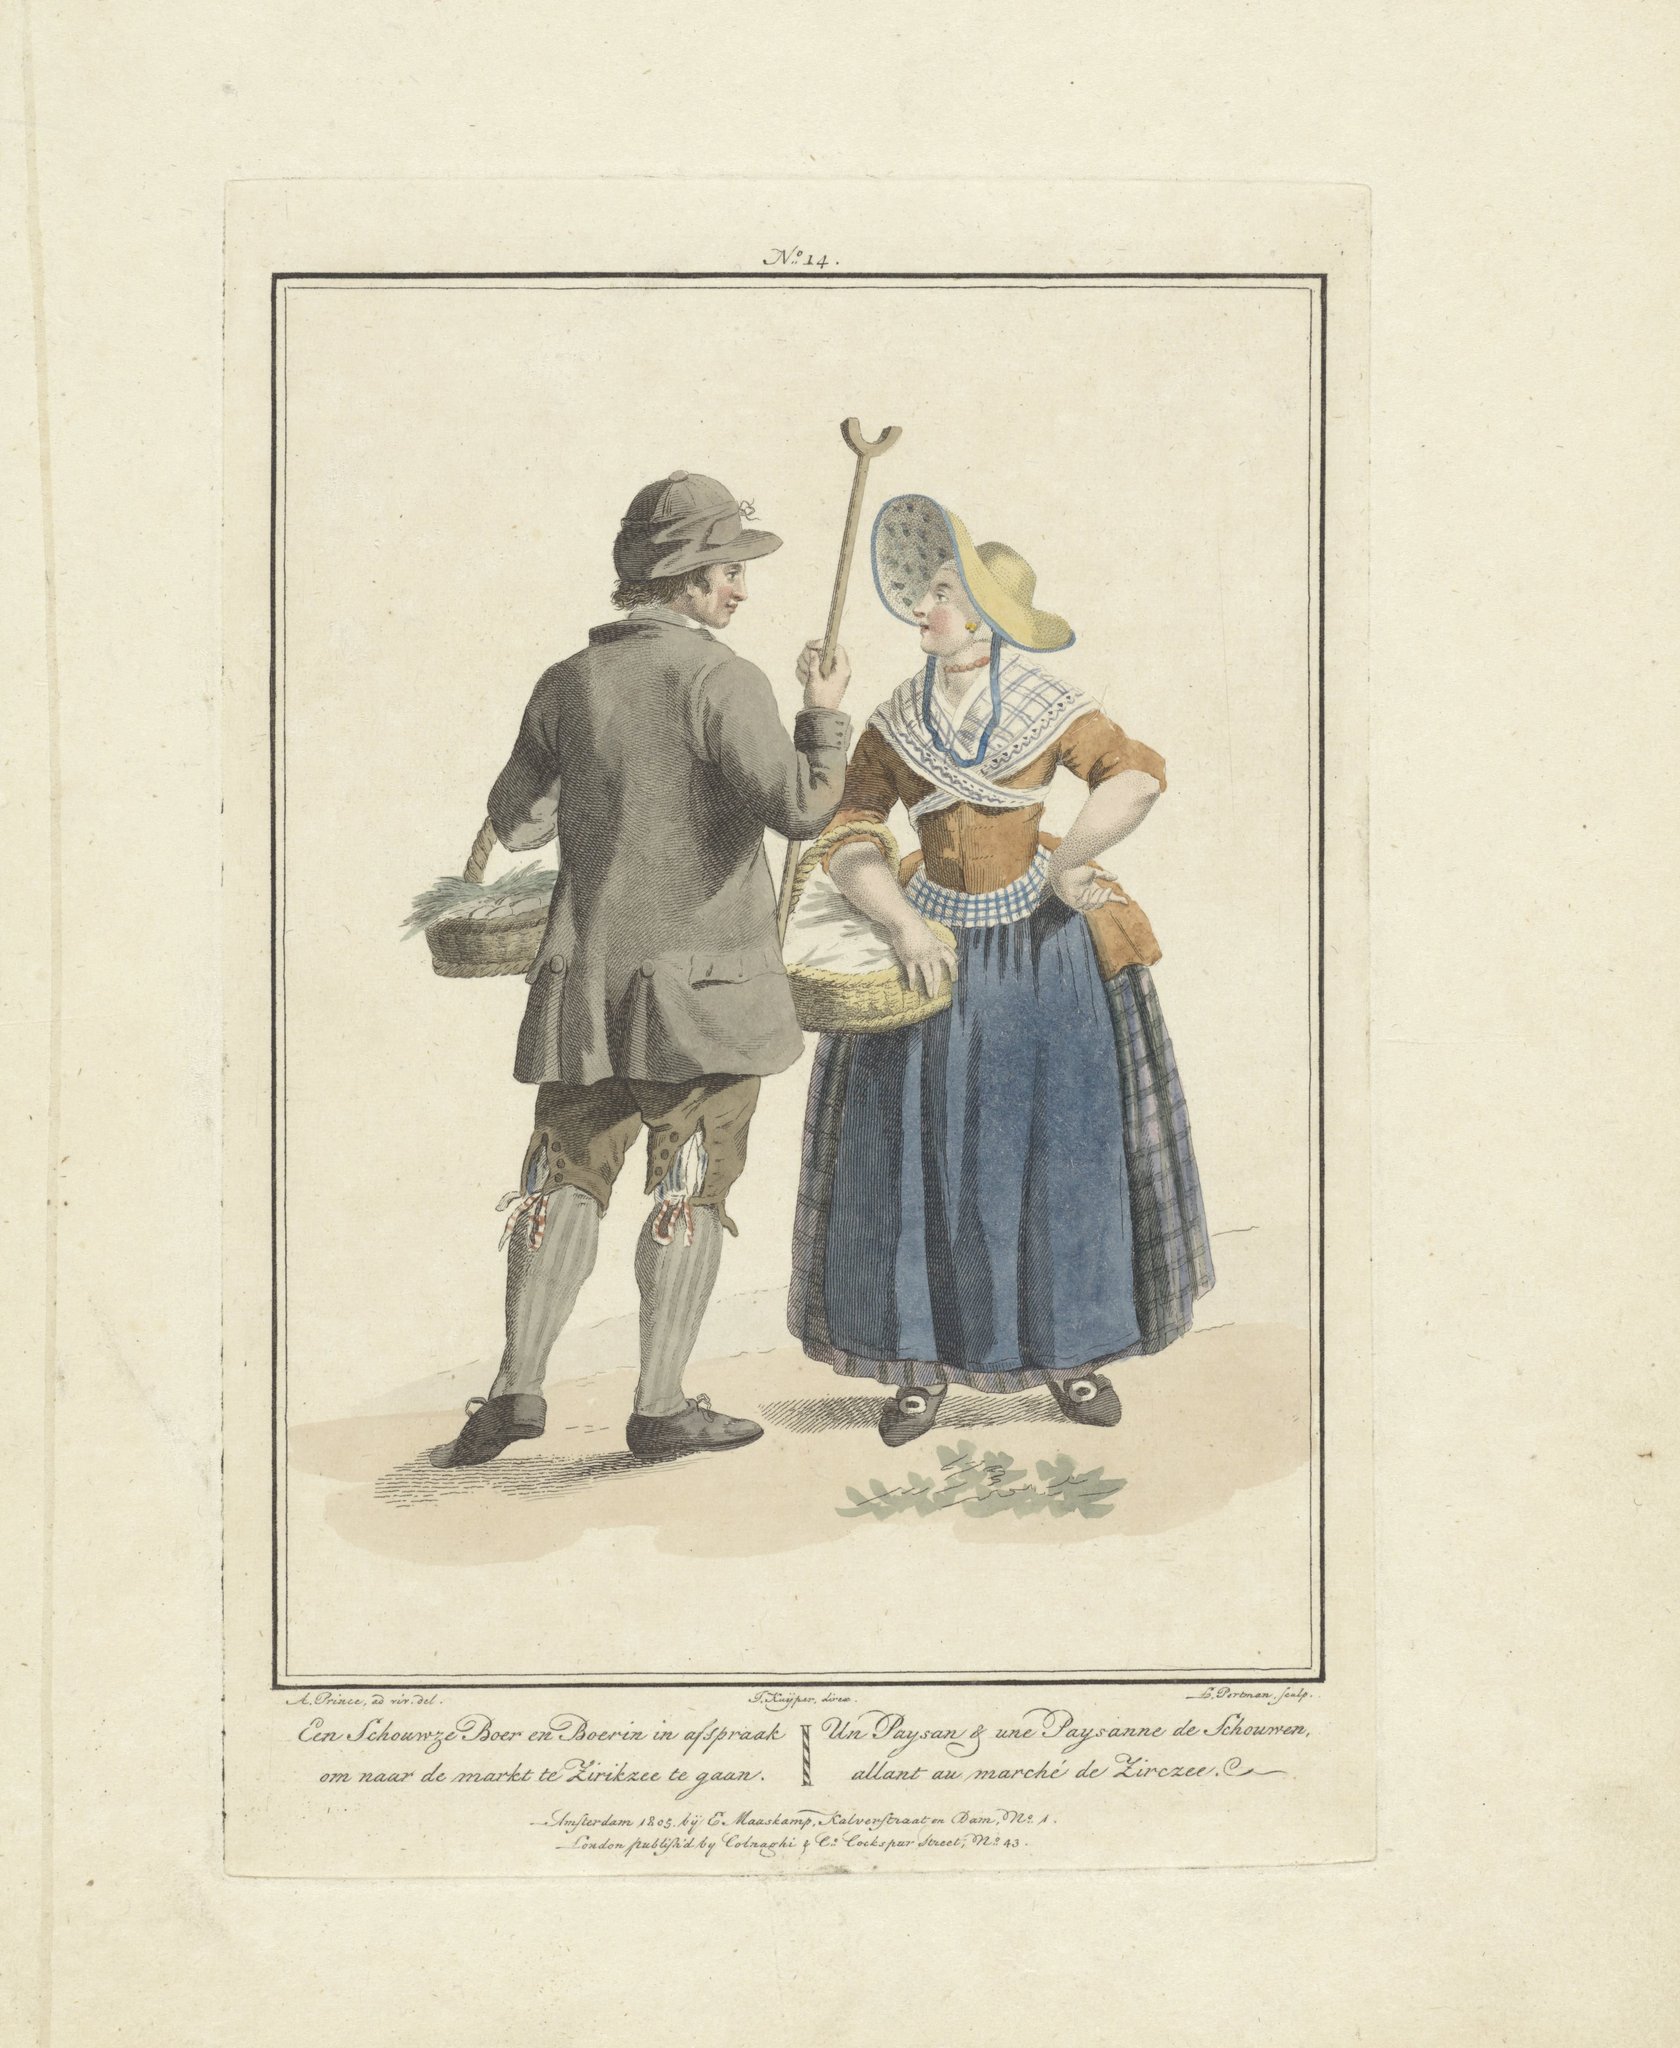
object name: costume print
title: Zeeuwse boer en boerin in klederdracht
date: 1803-1807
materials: paper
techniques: etching, hand coloring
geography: amsterdam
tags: going to the market, farmers, folk costume, regional costume, eggs, egg-dishes, zeeland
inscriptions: collector's mark: Lugt 2228, inscription: ‘Een Schouwze Boer en Boerin in afspraak om naar de markt te Zirikzee te gaan / Un Paysan et une Paysanne de Schouwen allant au marché de Zirezee.; m.b.: No. 14’, signature and date: ‘L. Portman sculp.; l.o.: A. Prince ad viv del.; m.o. J. Kuyper direx.; m.o. Amsterdam 1805, bij Maaskamp....London, published by Colnaghi & Cie...’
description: Illustratie uit: Afbeeldingen van de kleeding, zeden en gewoonten in de Bataafsche Republiek, met den aanvang der negentiende eeuw. Amsterdam: Evert Maaskamp, 1803-1807.